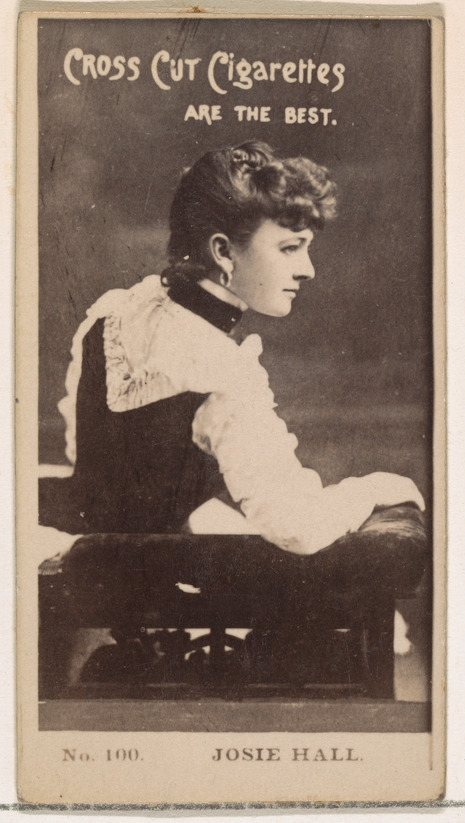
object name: print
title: Card Number 100, Josie Hall, from the Actors and Actresses series (N145-2) issued by Duke Sons & Co. to promote Cross Cut Cigarettes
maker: w. duke, sons & co.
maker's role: publisher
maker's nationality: american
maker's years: 1870-1920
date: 1880-1889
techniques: albumen silver print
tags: women,actresses